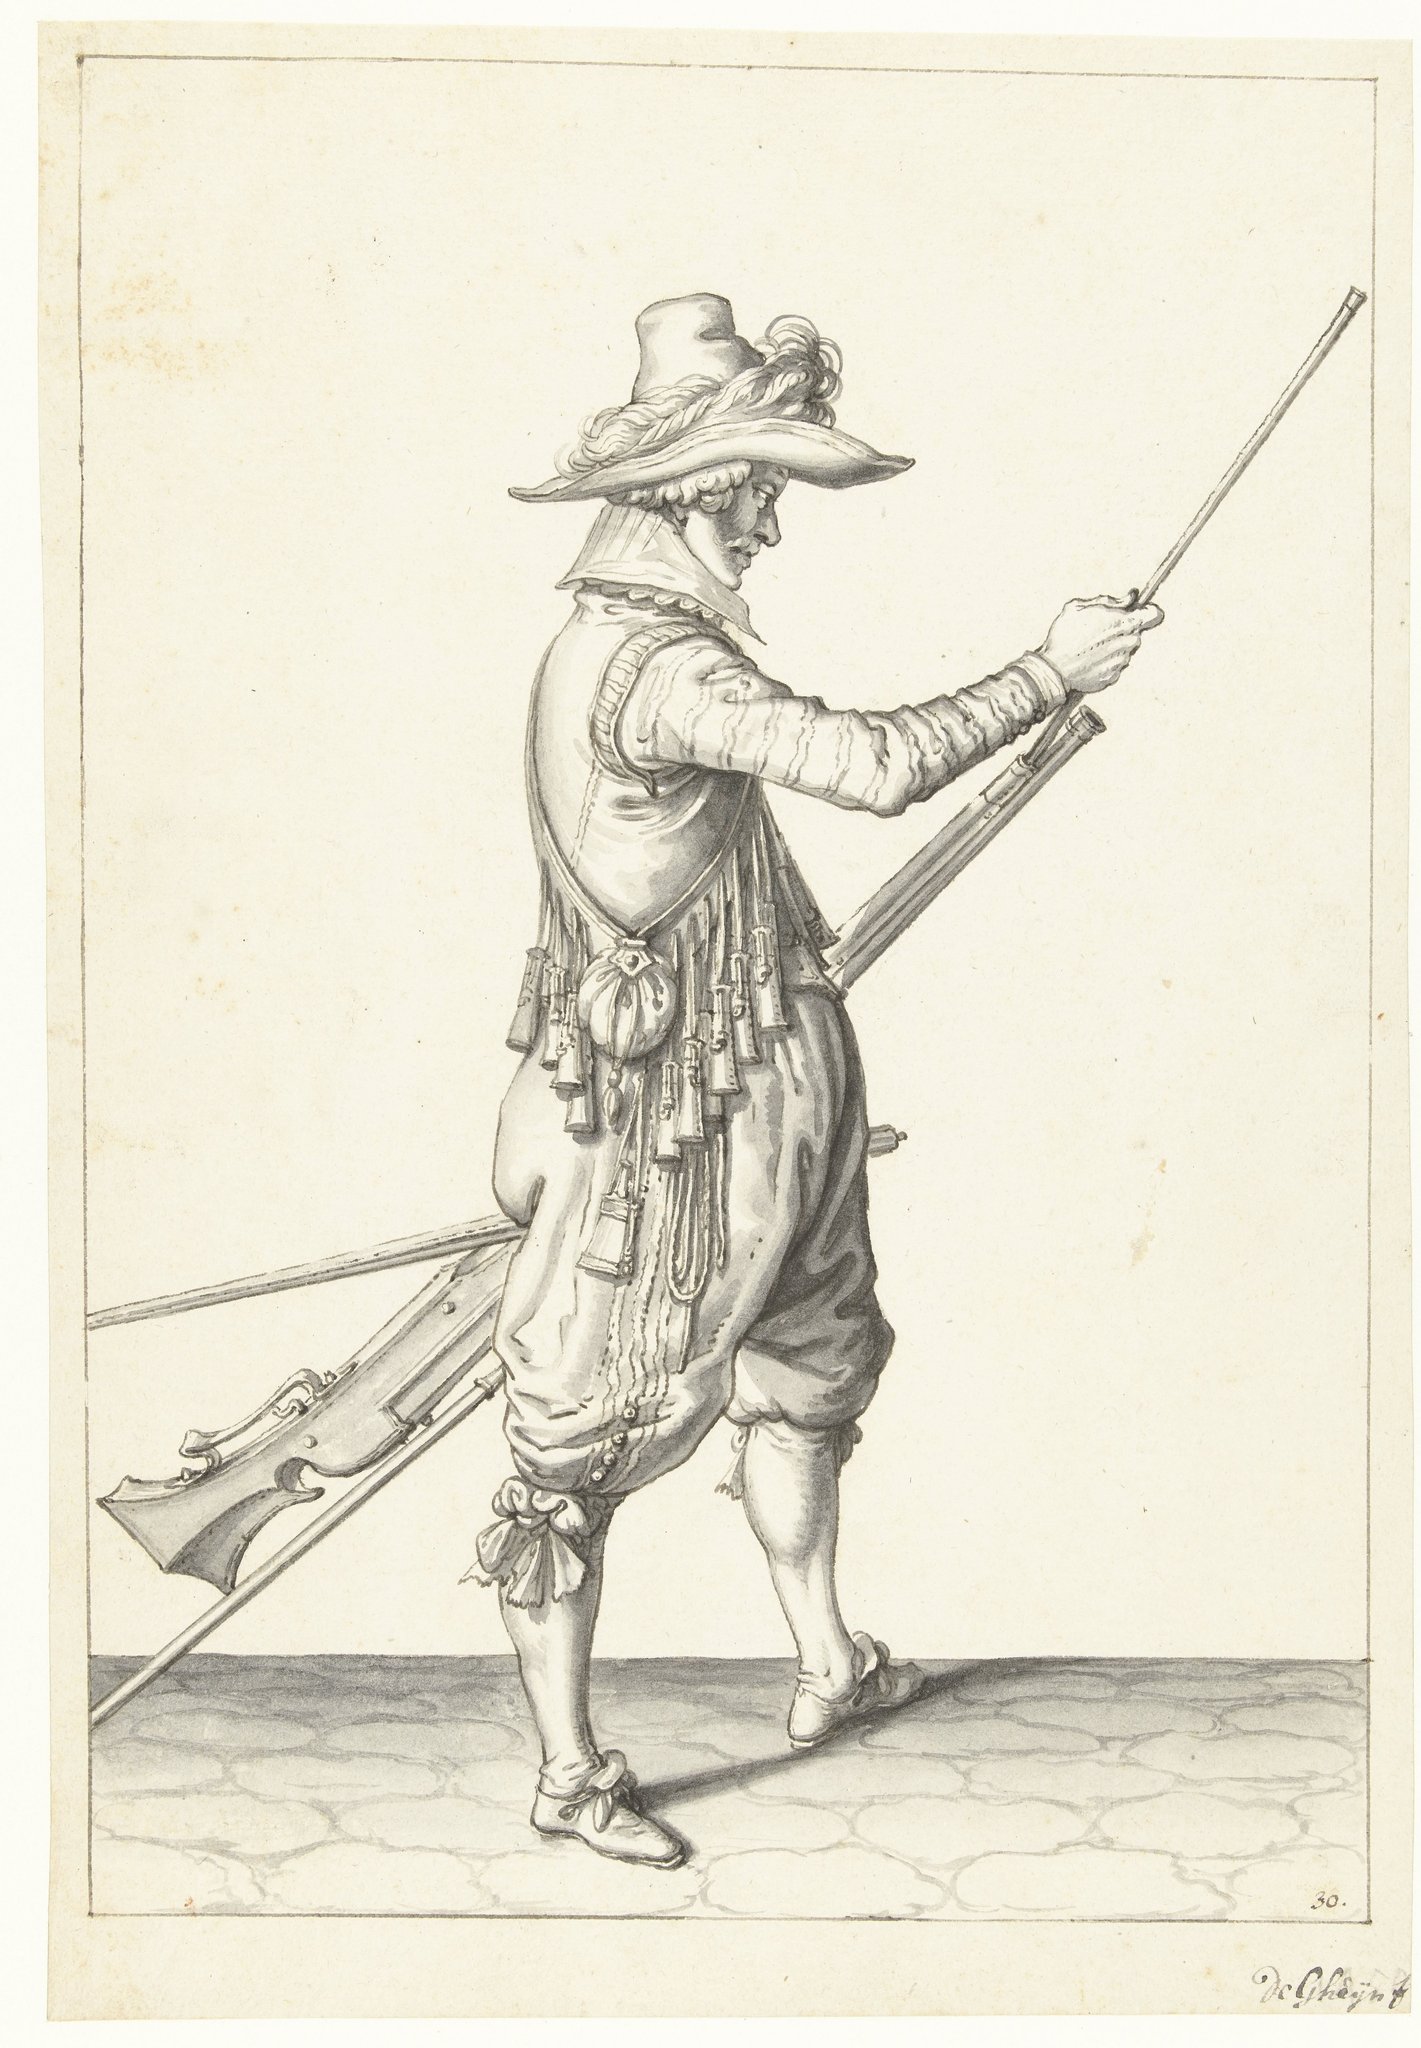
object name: design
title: Wapenhandelinghe van Musquetten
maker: jacques de gheyn (ii)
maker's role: painter, print maker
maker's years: 1565-1629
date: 1596-1606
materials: ink, paper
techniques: brush, pen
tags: handling of weapons ~ military training